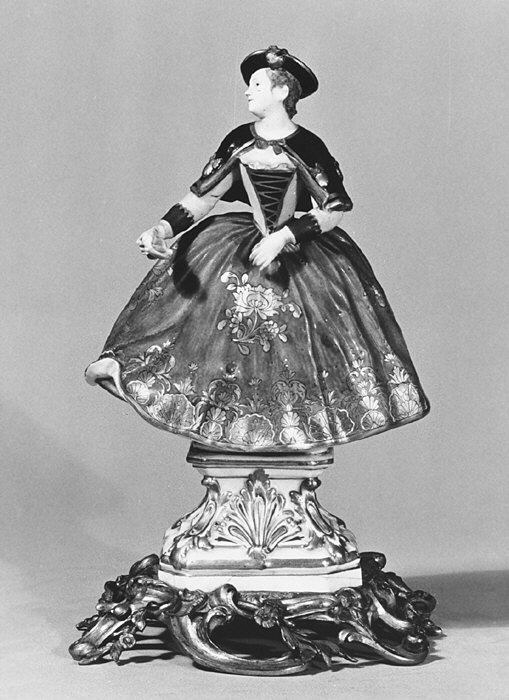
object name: figure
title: Standing woman (one of a pair)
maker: meissen manufactory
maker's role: manufactory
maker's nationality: german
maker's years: 1710-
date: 1745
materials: gilt bronze, hard paste porcelain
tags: women